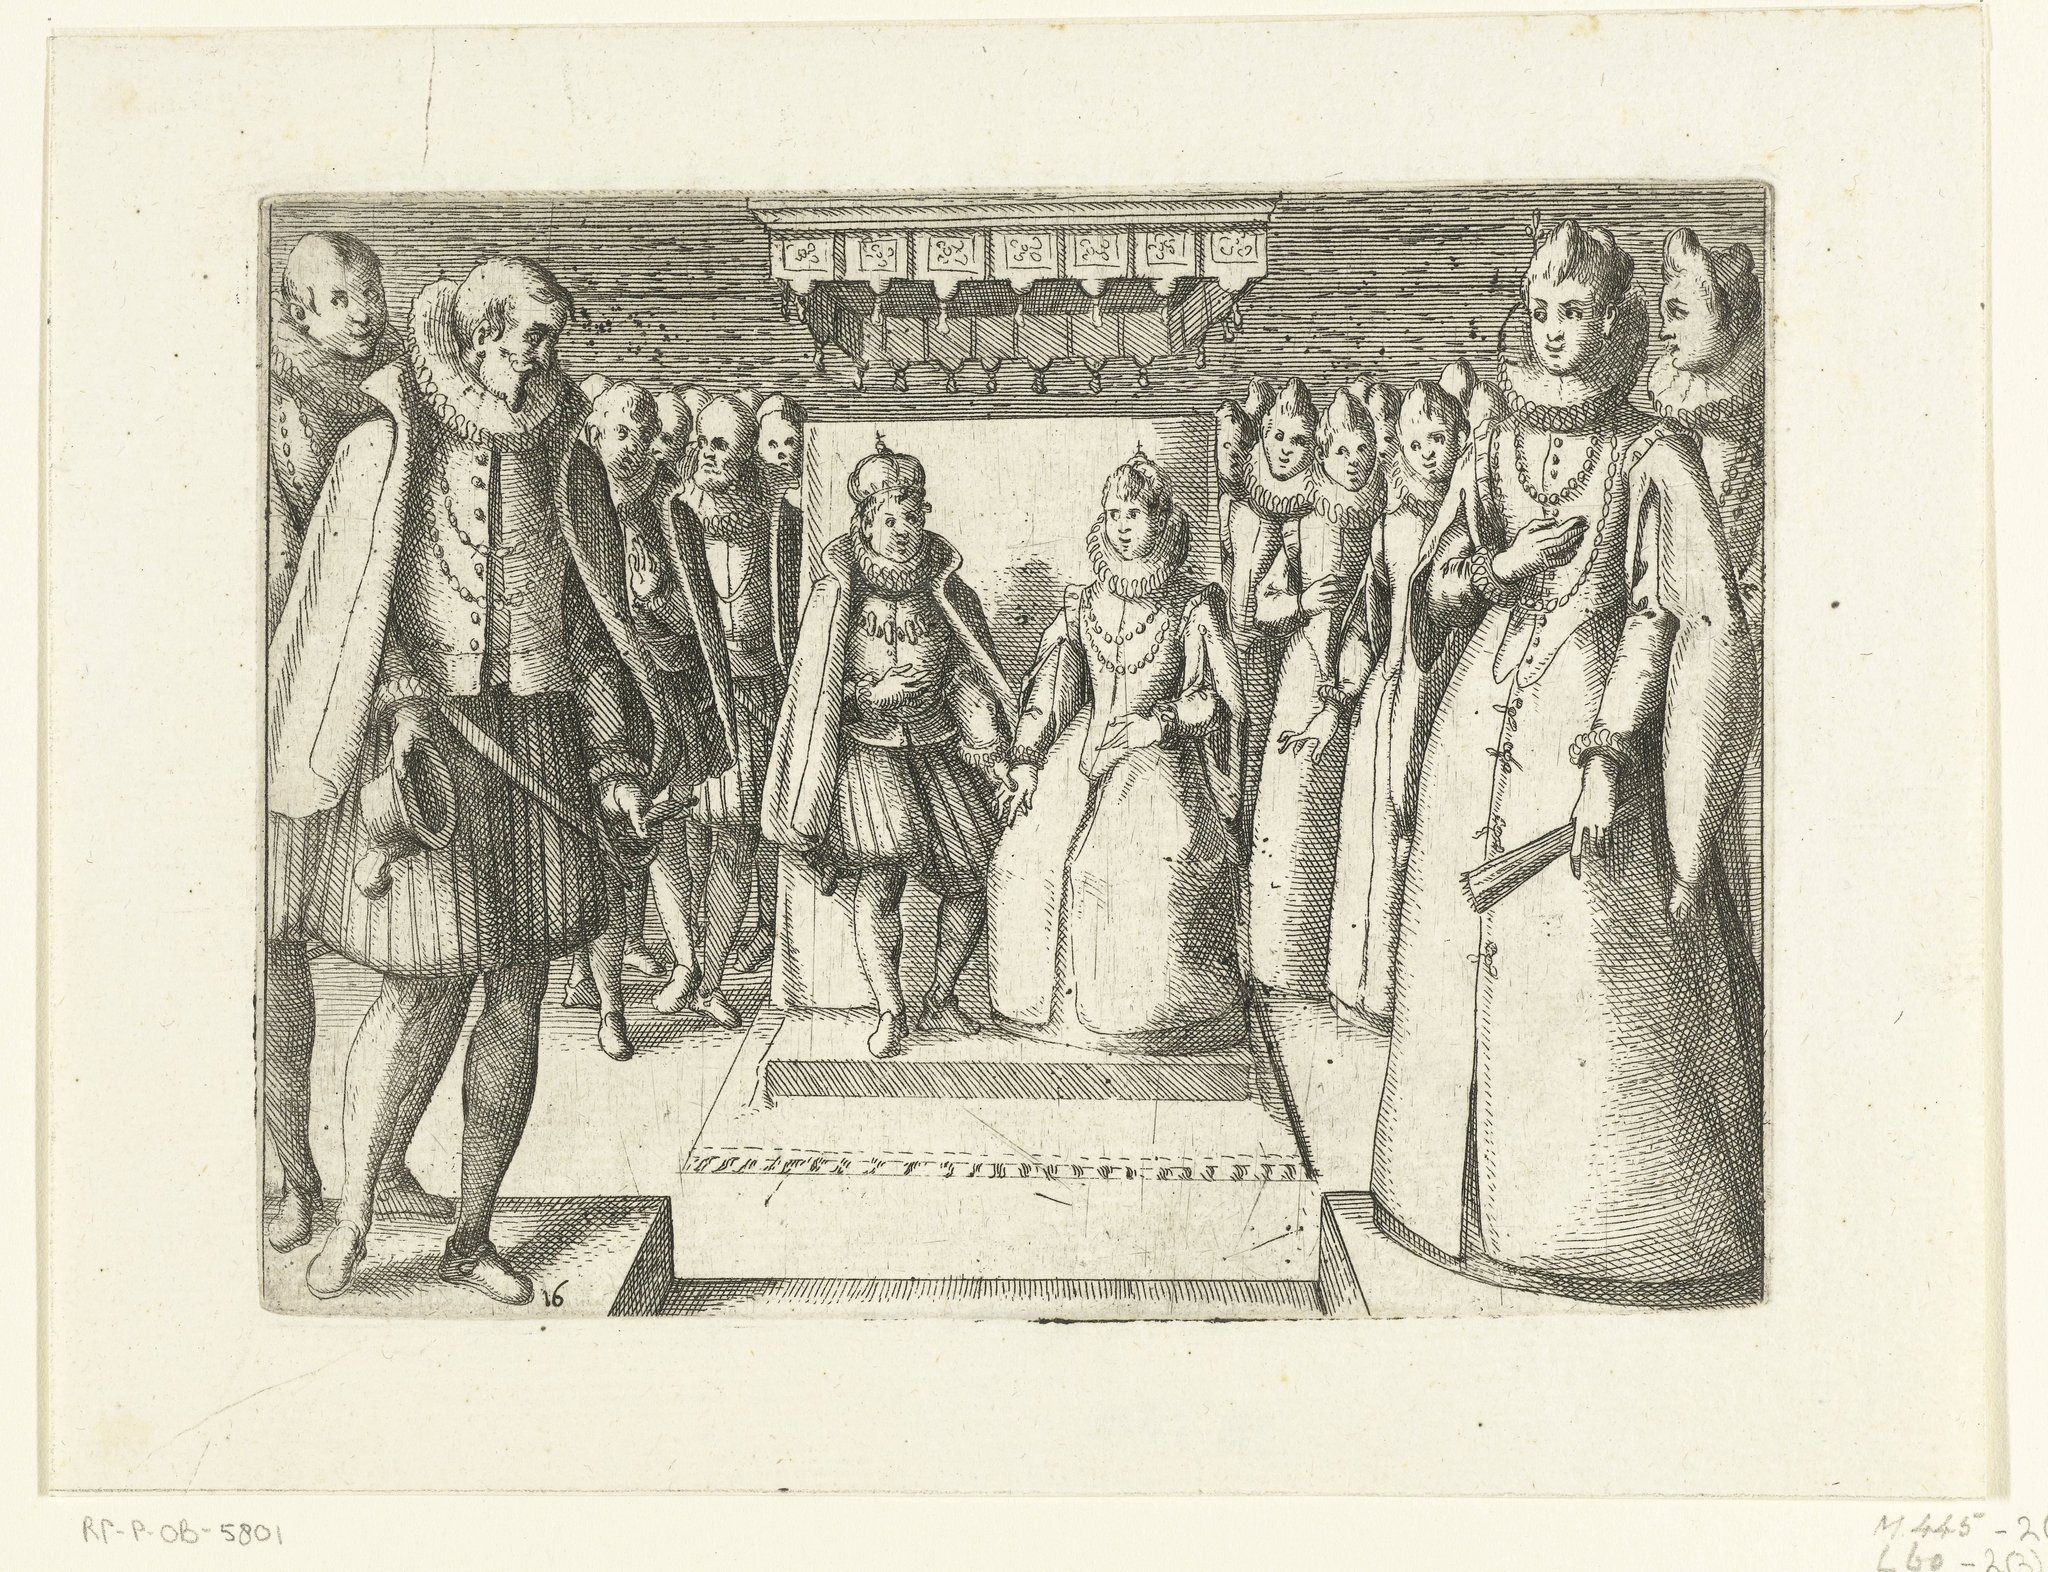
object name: print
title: Onderhoud van Margaretha van Oostenrijk met Filips III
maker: jacques callot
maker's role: draughtsman, print maker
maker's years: 1592-1635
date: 1612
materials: paper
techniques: etching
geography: florence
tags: margaretha van oostenrijk (koningin van spanje), filips iii (koning van spanje), royal household; courtiers, retinue, train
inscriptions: collector's mark: Lugt 240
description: Een man en een vrouw op een troon (Filips III en Margaretha van Oostenrijk?), geflankeerd door een groep mannelijke hovelingen (vooraan Filips III?) en een groep vrouwelijke hovelingen (vooraan Margaretha van Oostenrijk?).